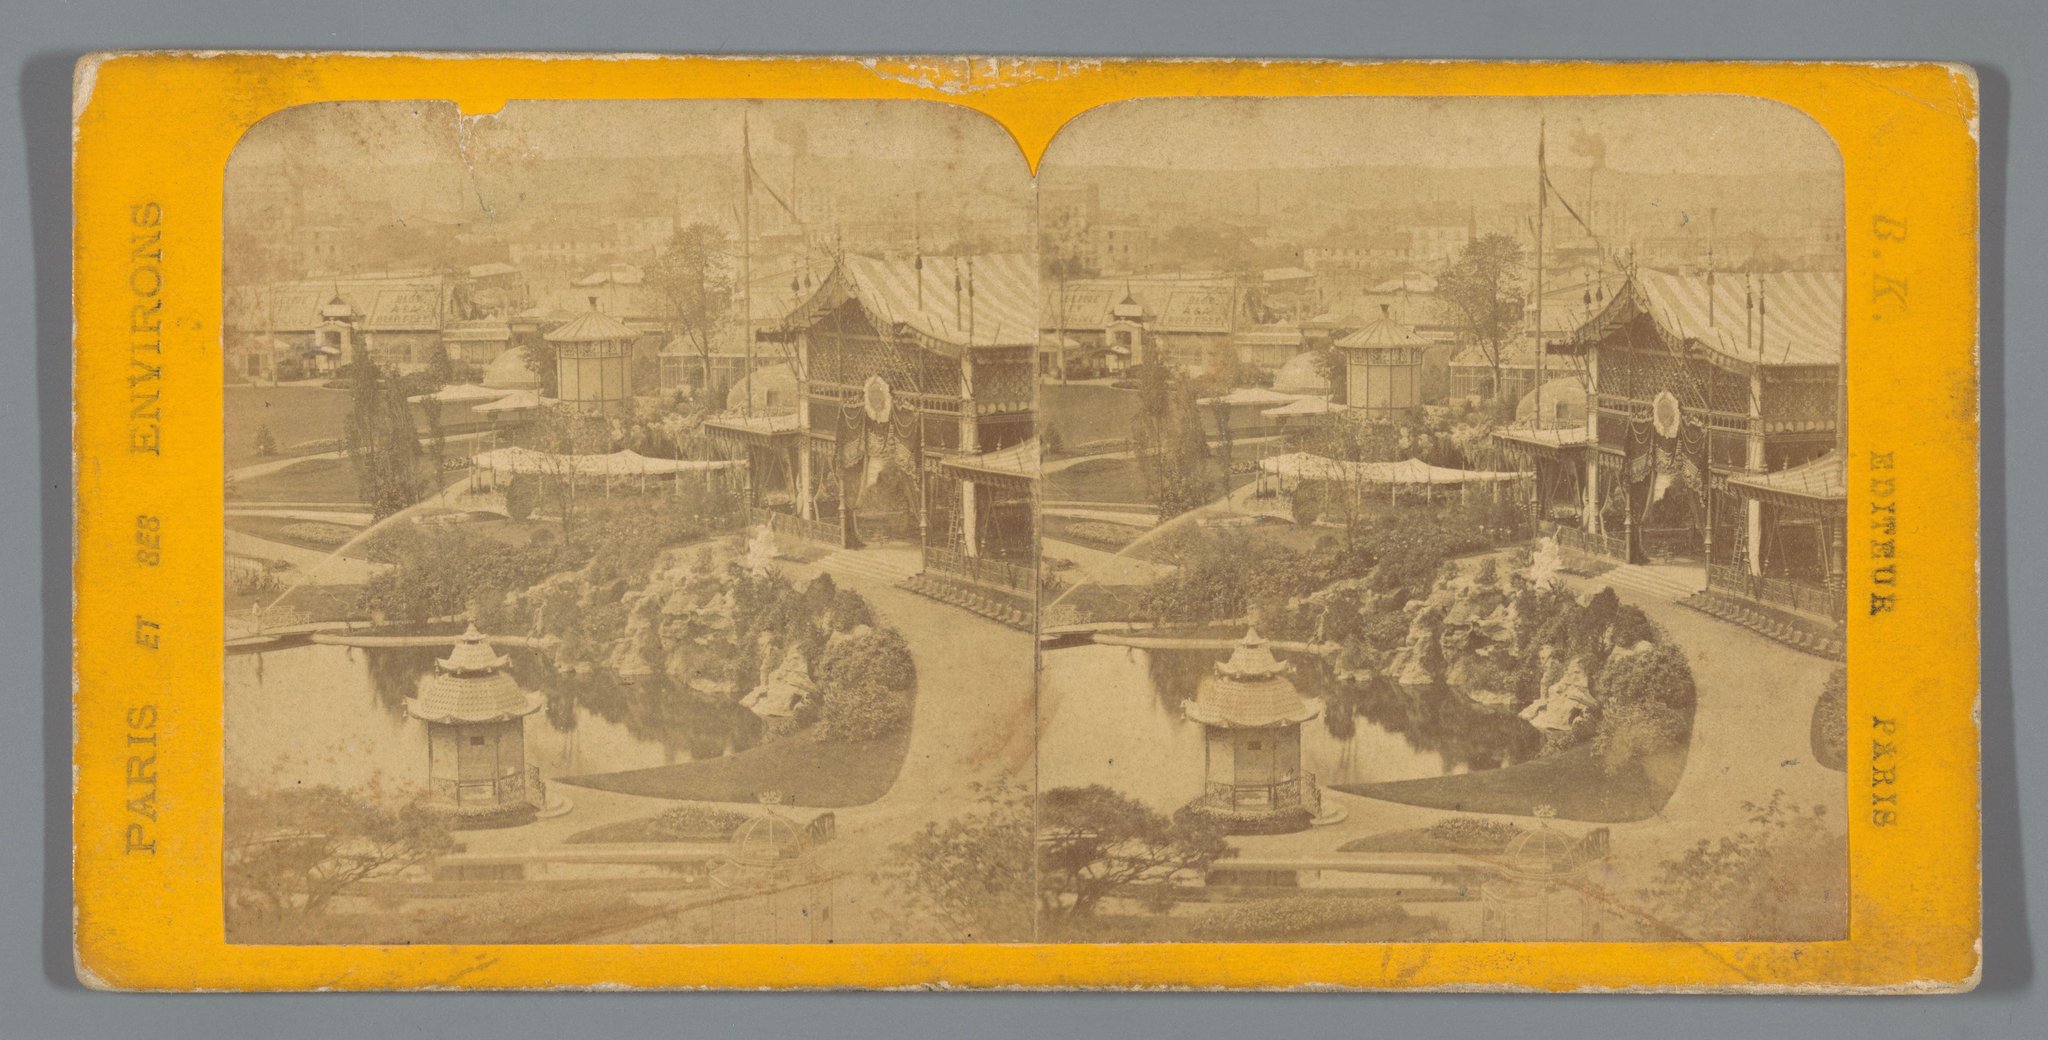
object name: stereograph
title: Wereldtentoonstelling van 1867 in Parijs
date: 1867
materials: cardboard, paper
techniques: albumen print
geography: paris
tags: world fair, world exhibition, paris